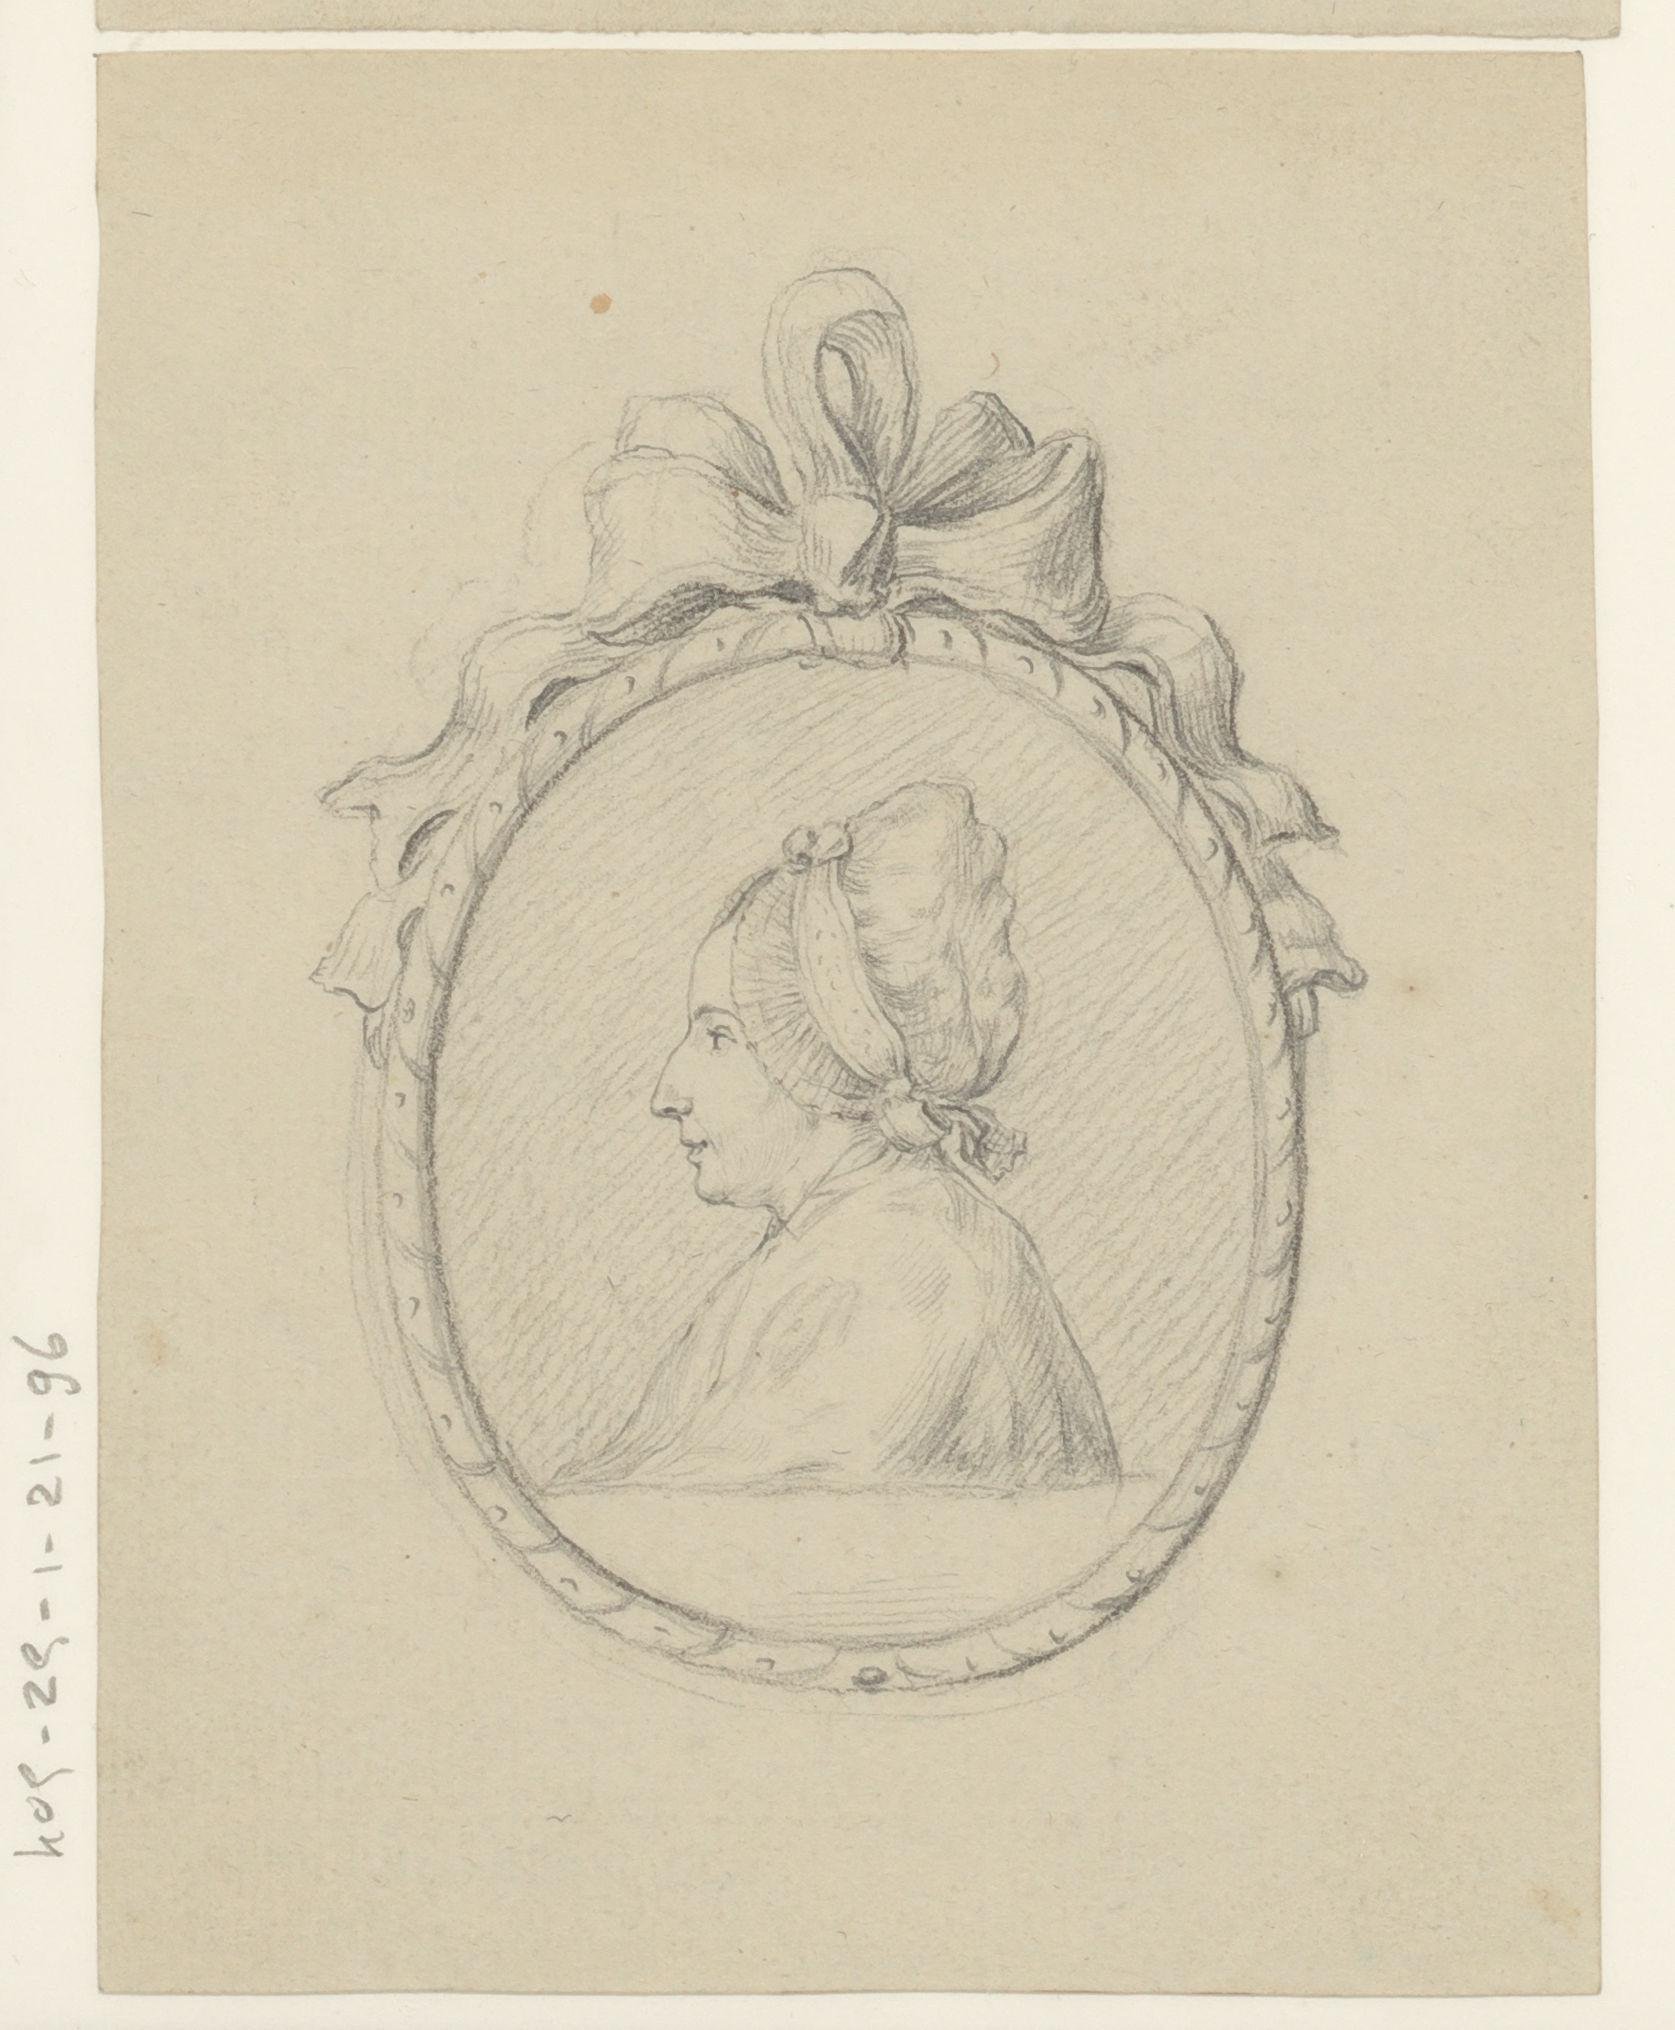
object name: drawing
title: Portret van een vrouw in een medaillon, mogelijk de zus van Jean Bernard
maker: jean bernard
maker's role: draughtsman, print maker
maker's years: 1765-1833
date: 1775-1833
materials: chalk, paper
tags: historical persons not known by name - bb - woman, ornament ~ medallion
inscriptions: collector's mark: Lugt 1641, stamp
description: Onderwerpsrubrieken binnen de Atlas Zeden en Gewoonten: Zeden en Gewoonten in Engeren Zin, De Kleeding, Kleederdrachten (tijdvakken), De 18de eeuw (de pruikentijd). Mannen en vrouwen.